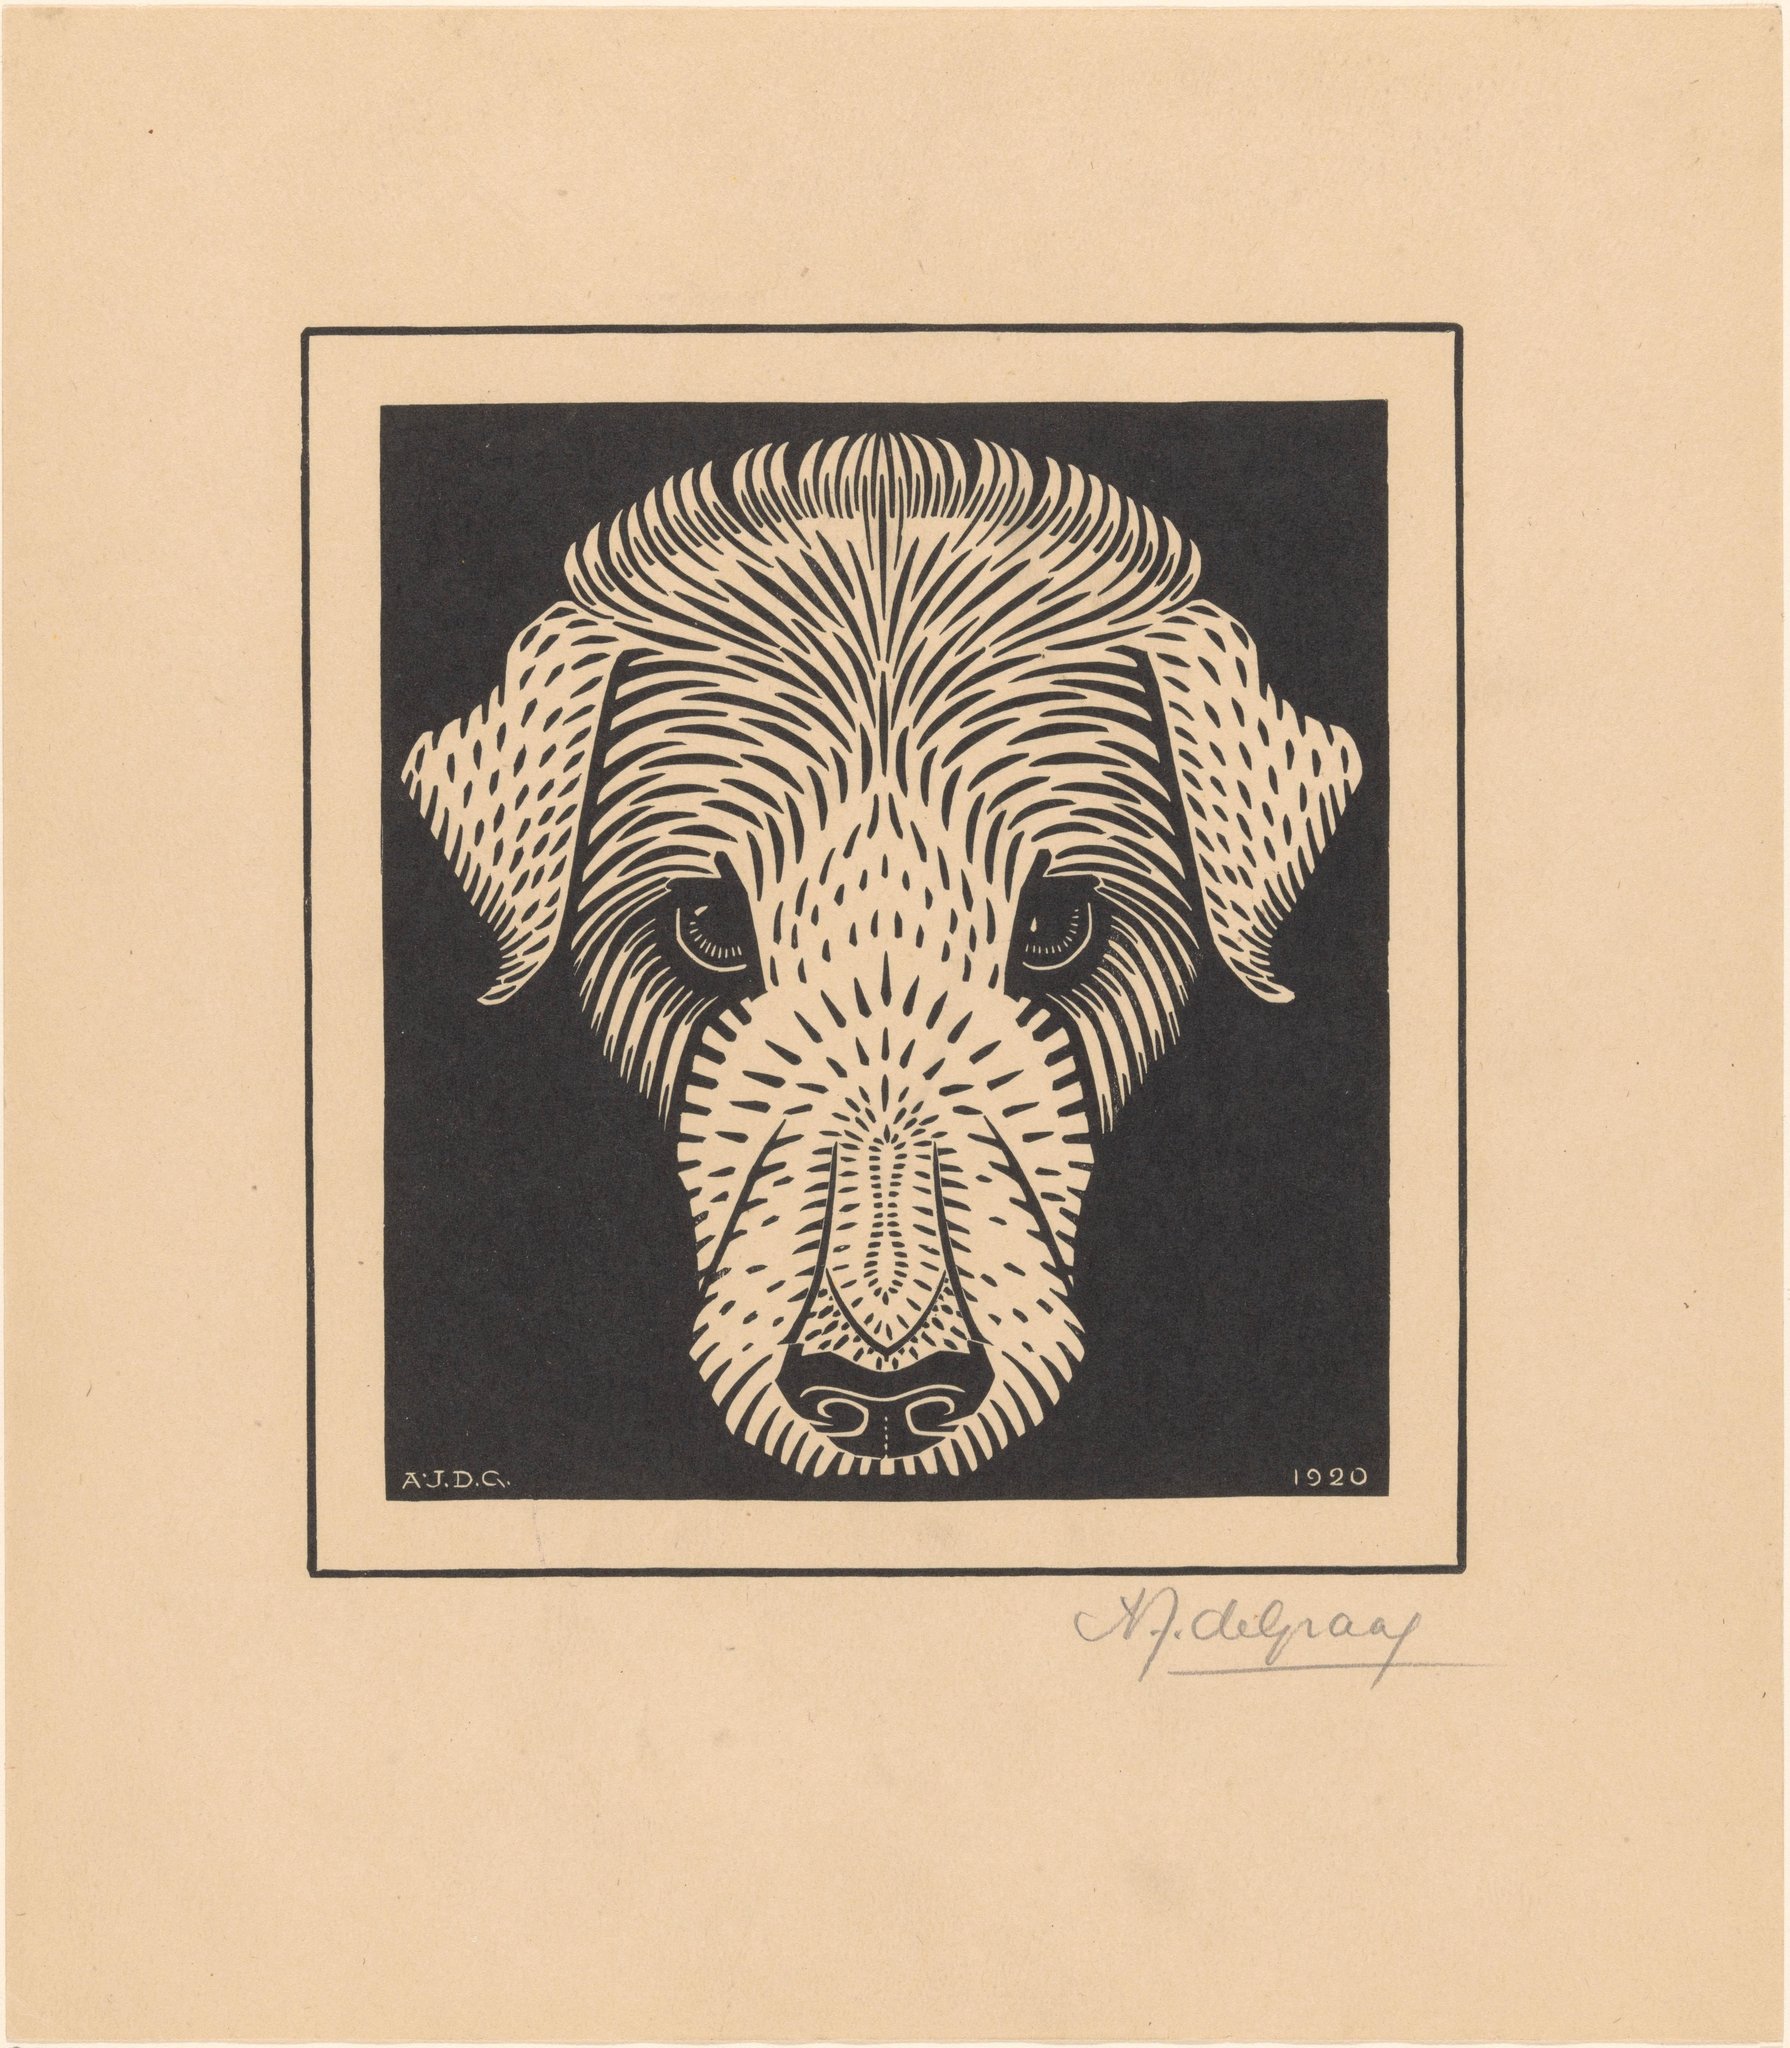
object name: print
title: Hondenkop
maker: julie de graag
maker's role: draughtsman, print maker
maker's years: 1877-1924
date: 1920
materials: paper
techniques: woodcut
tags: dog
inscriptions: collector's mark: Lugt 2228